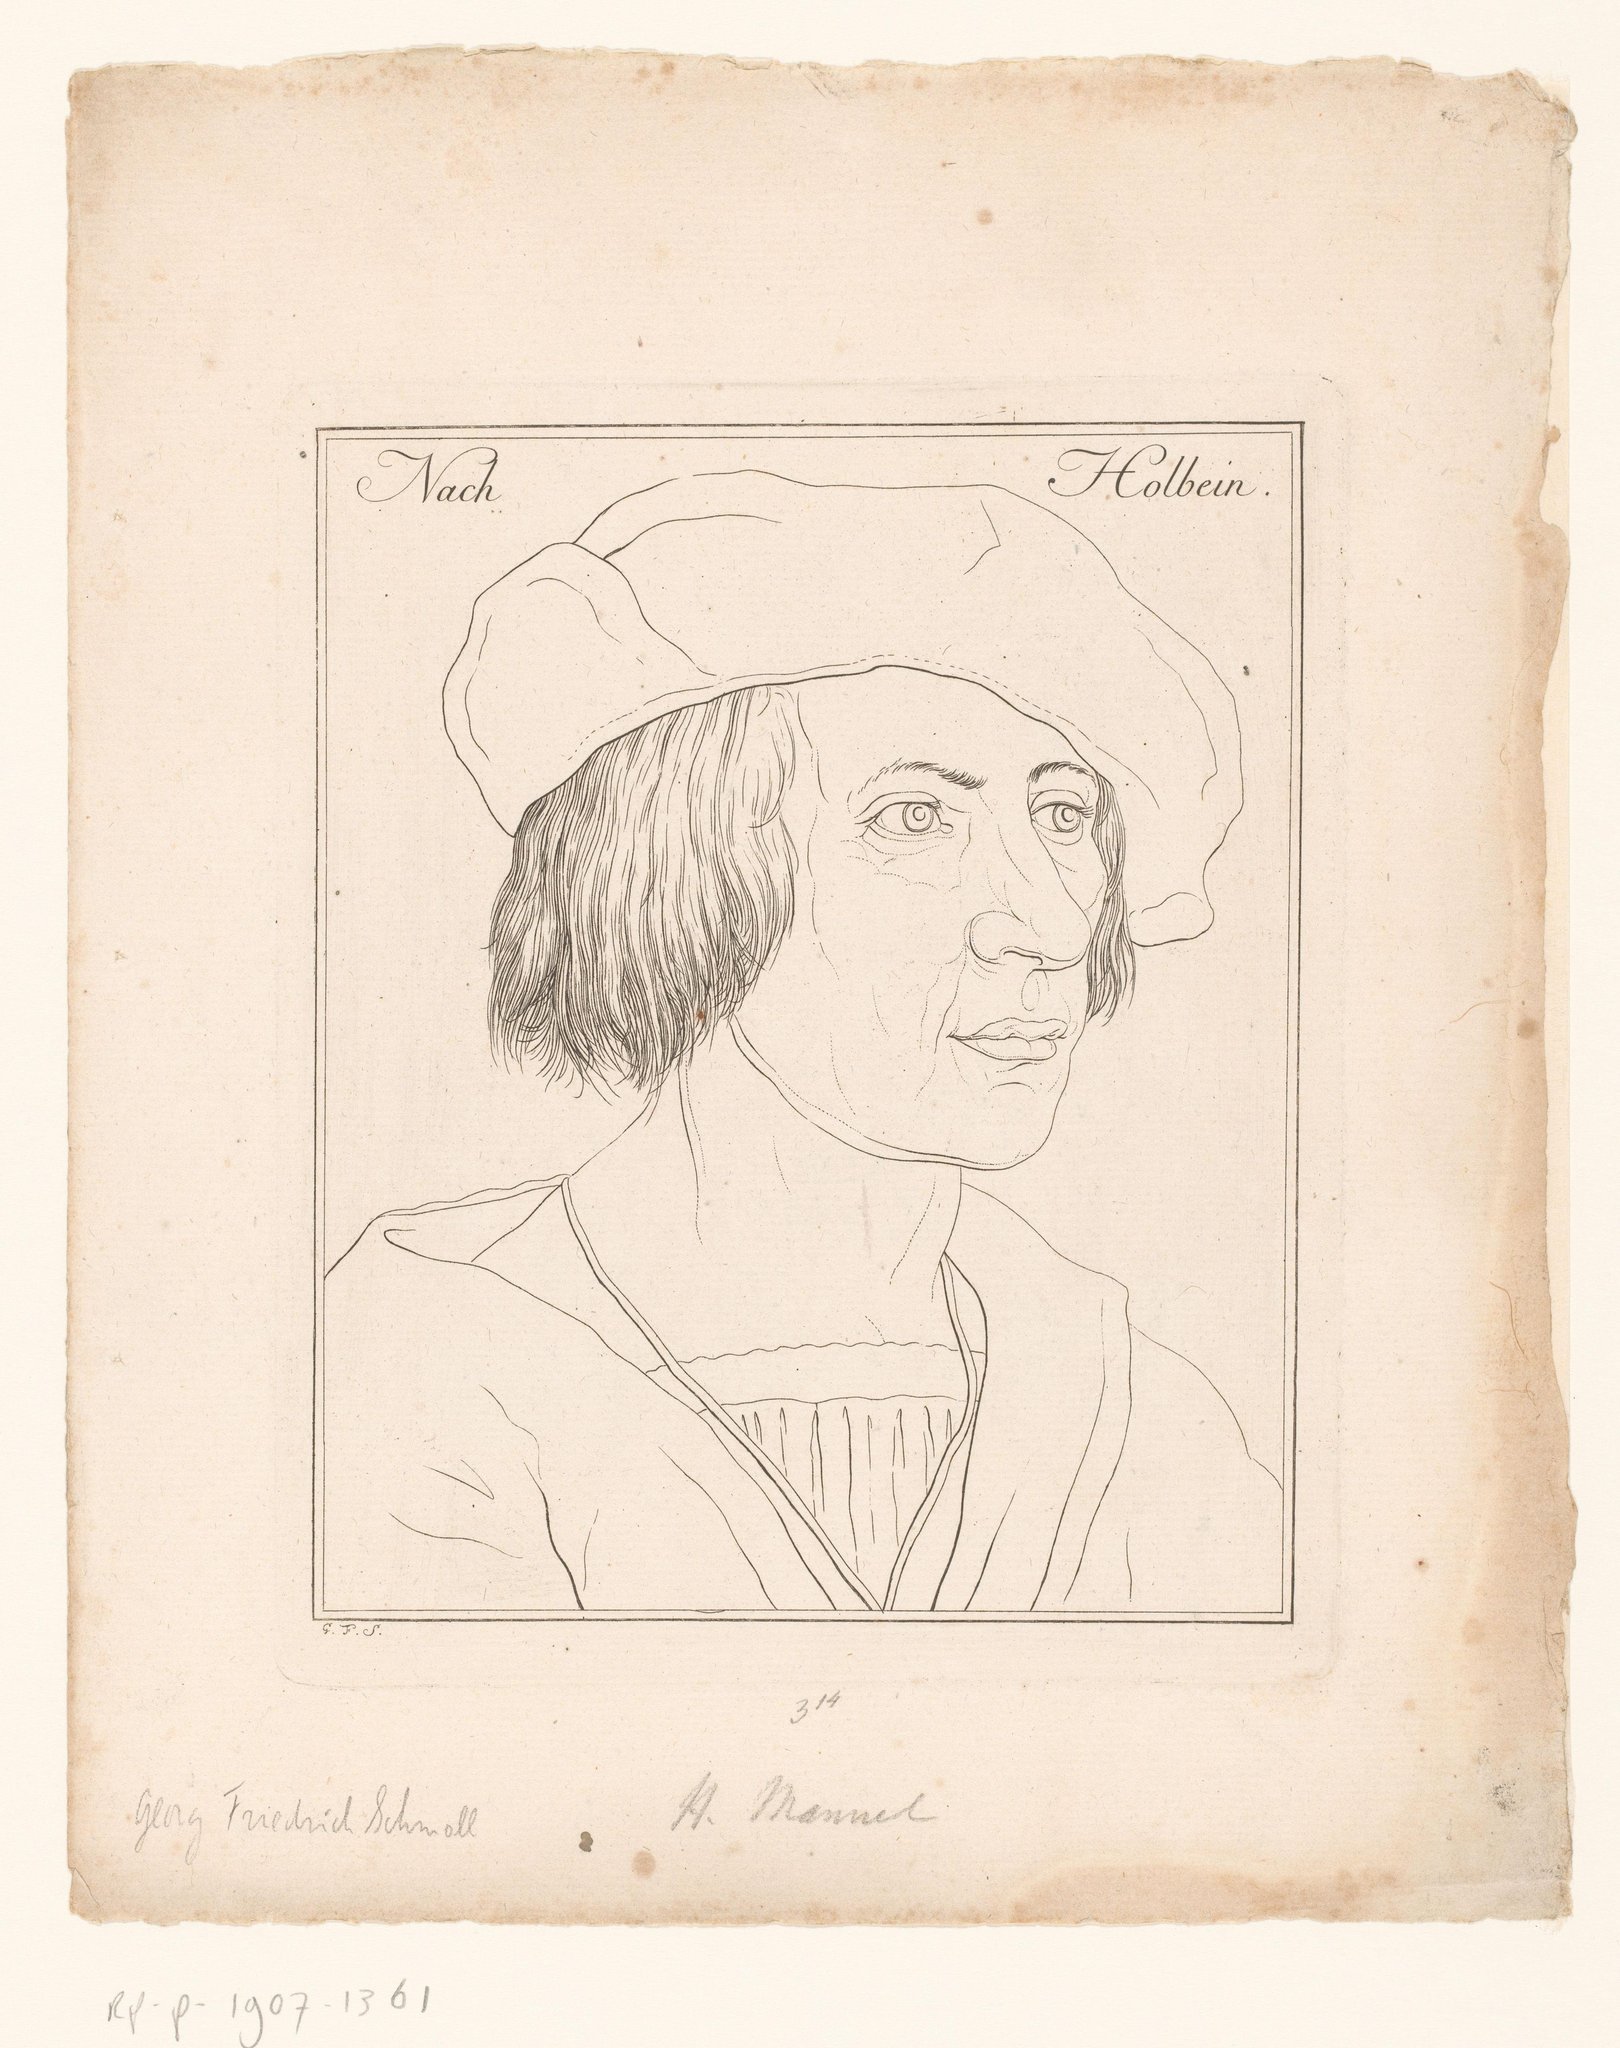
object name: print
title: Portret van Niklaus Manuel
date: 1700-1785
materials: paper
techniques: etching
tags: print maker, niklaus manuel deutsch, historical persons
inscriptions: collector's mark: Lugt 2228